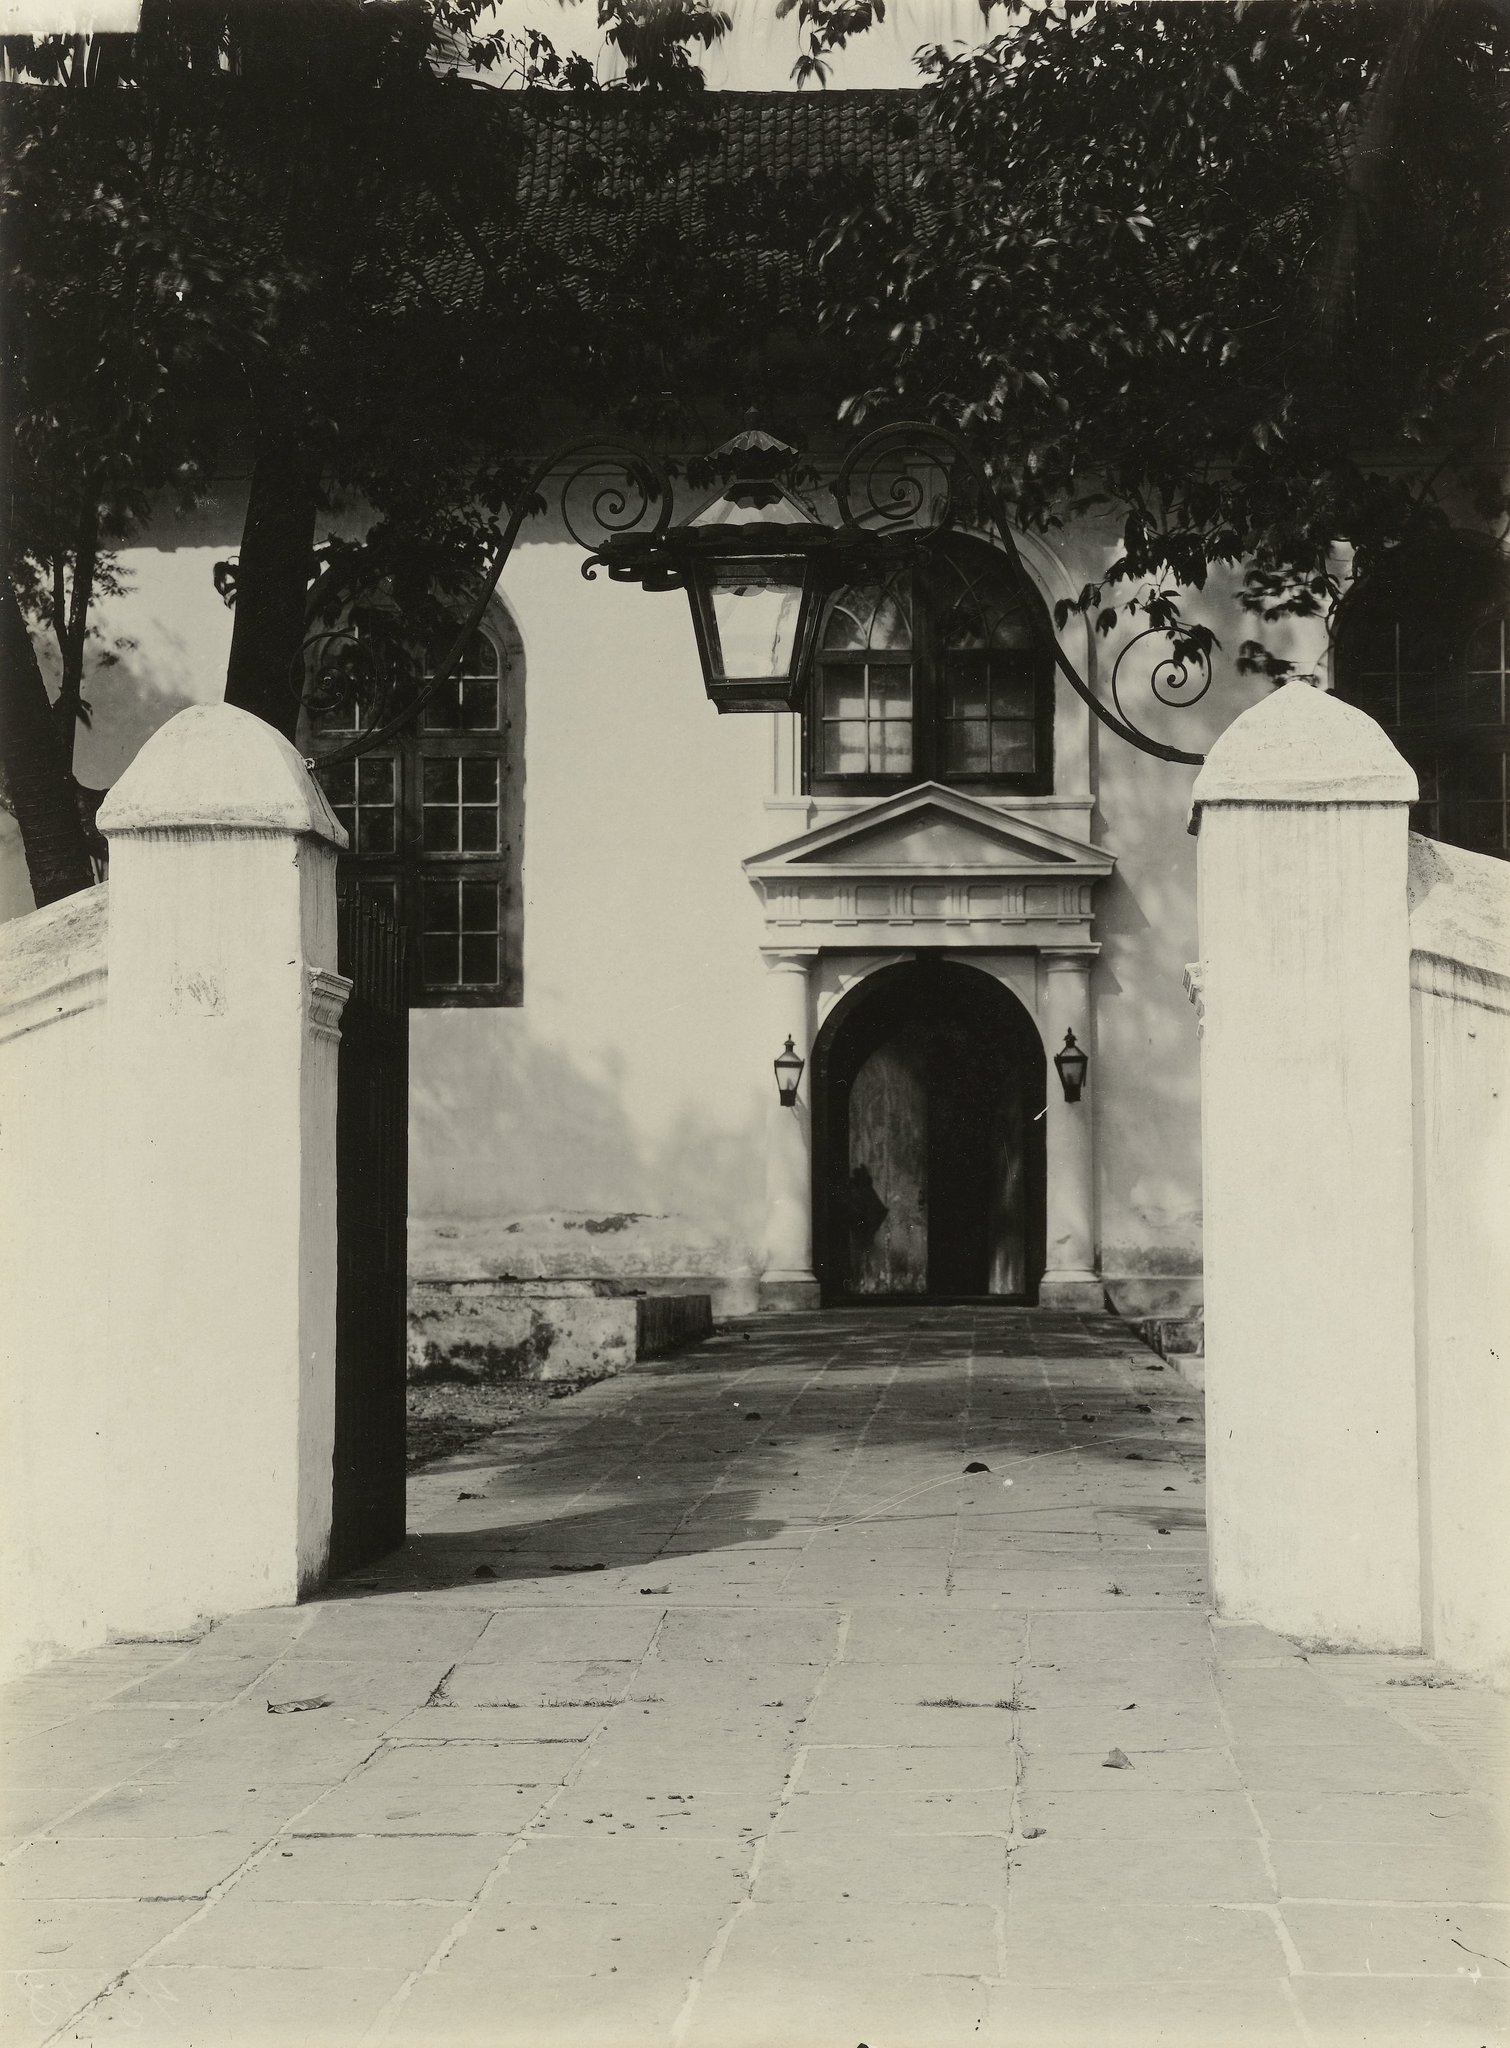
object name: photograph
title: Nederlandse gebouwen in Batavia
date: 1900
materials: paper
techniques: photography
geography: batavia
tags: dutch east indies, the, batavia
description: Eén van zes foto's (zwart-wit) van Nederlandse gebouwen en de Chinese wijk in Batavia (Jakarta), Nederlands-Indië. Merken; achterzijde: stempel: 'chef van den oudheidkundige dienst' en wapen van Nederland. Opmerking: zie NG-1009-A t/m F.